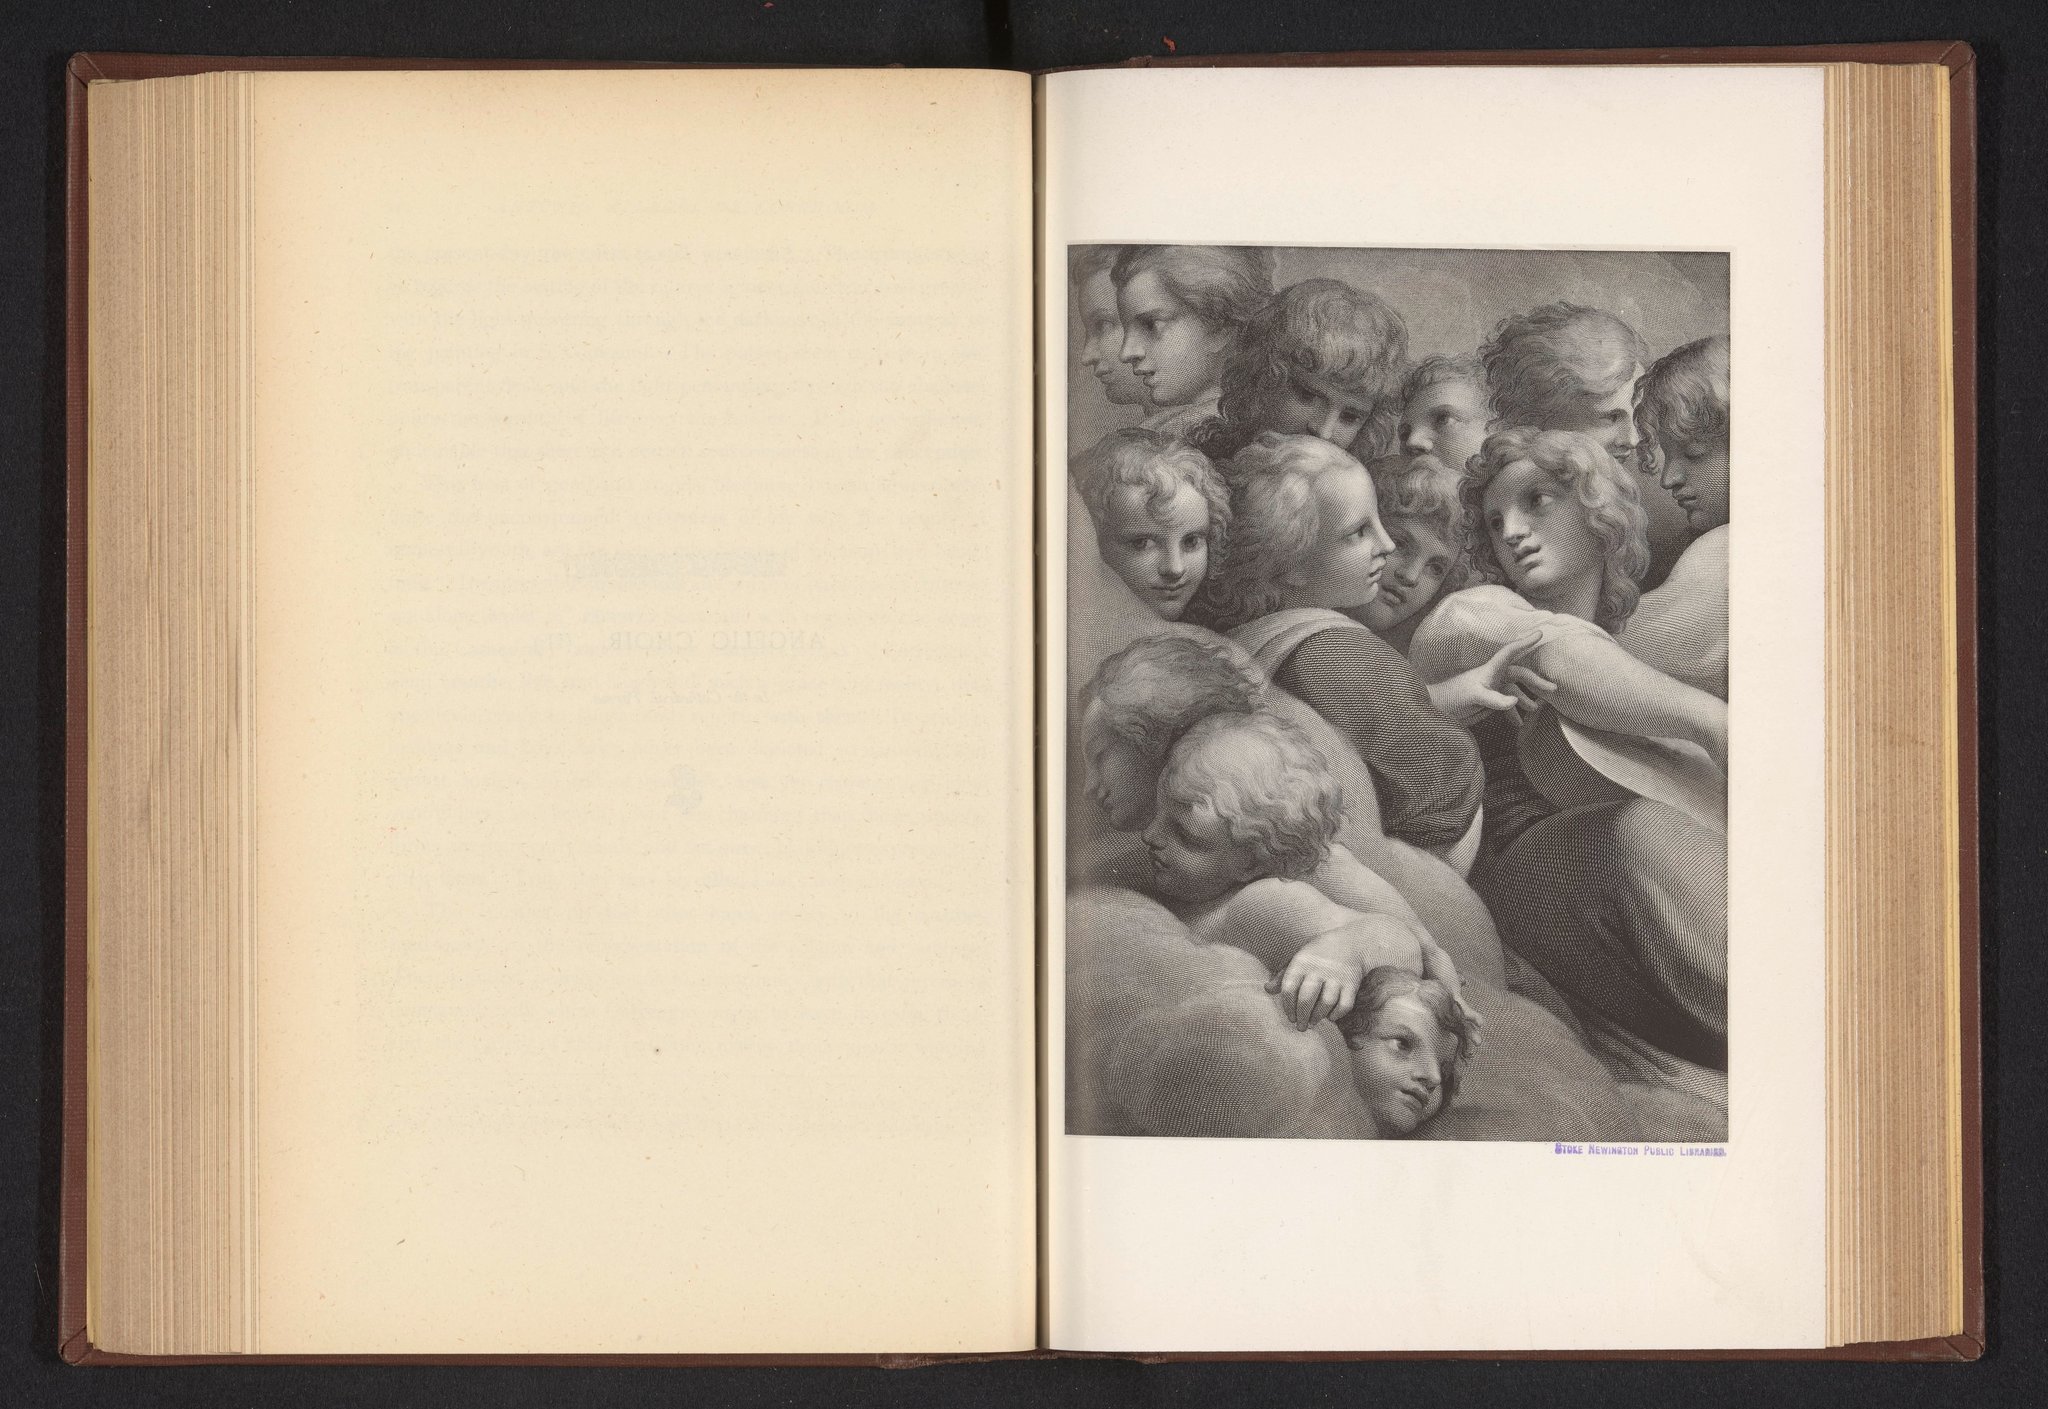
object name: page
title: Fotoreproductie van een prent naar een schildering, voorstellende een koor van engelen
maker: Anonymous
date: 1870-1876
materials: paper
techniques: photograph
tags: angels singing, making music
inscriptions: inscription: ‘Stoke Newington Public Libraries’